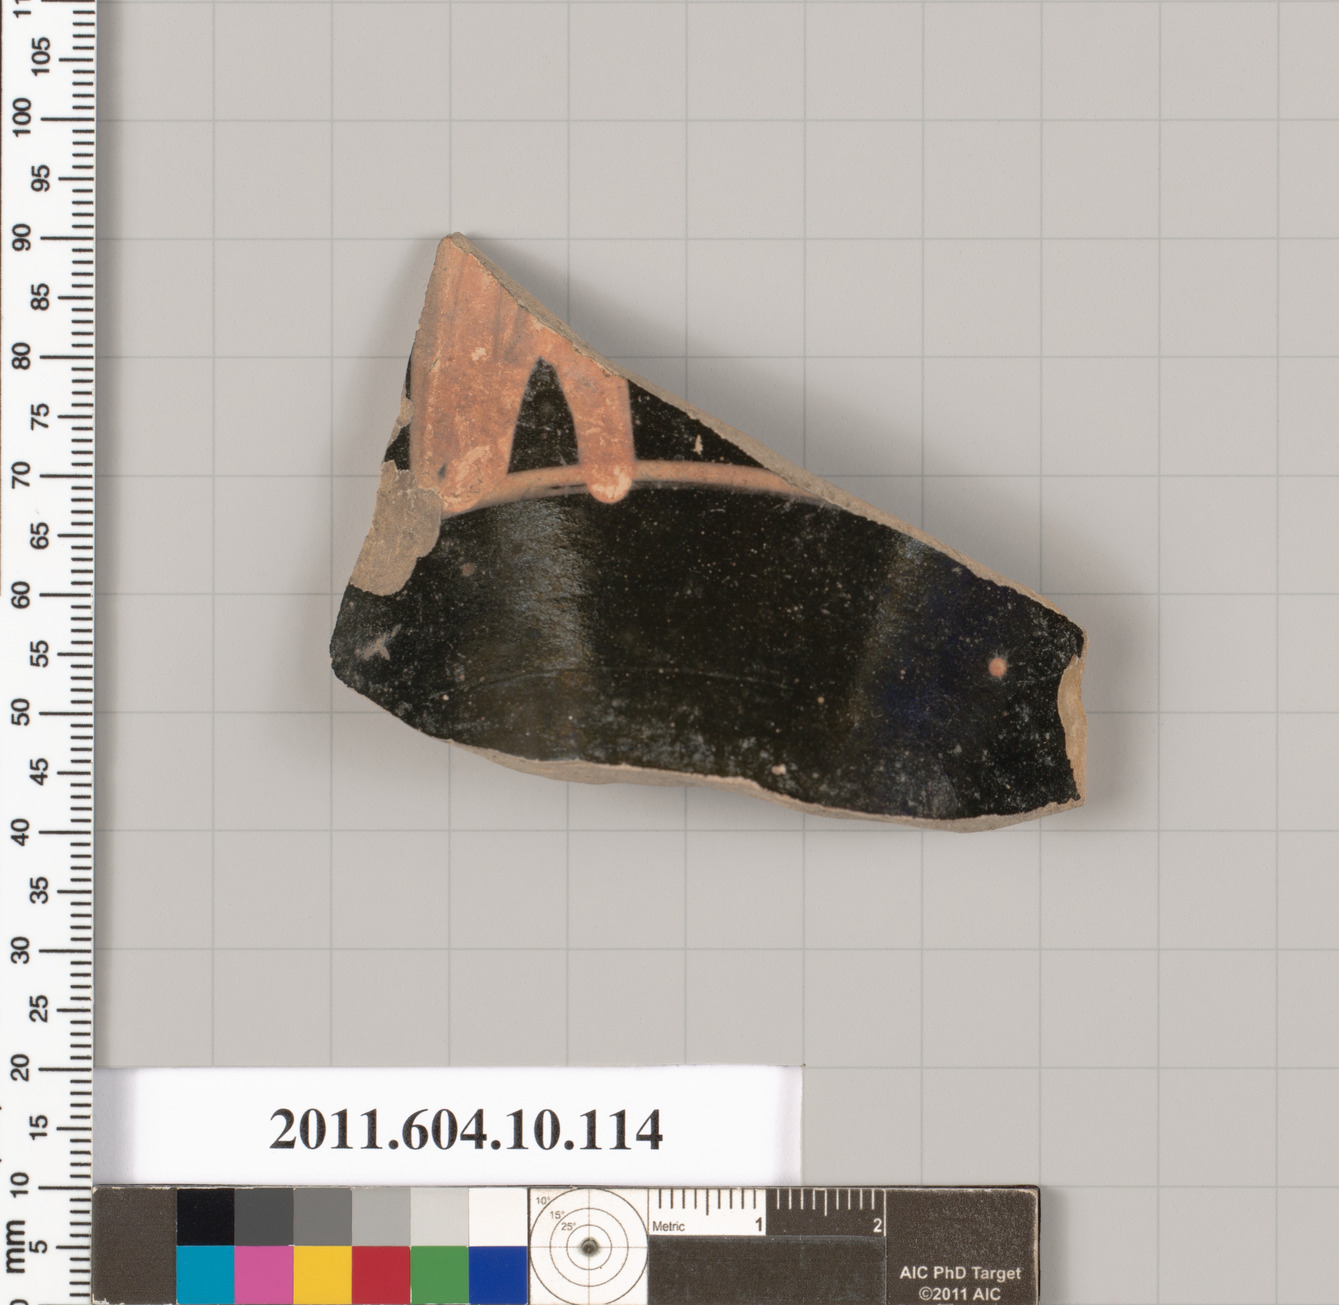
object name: undetermined open shape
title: Terracotta fragment of an open shape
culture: etruscan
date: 434-368 BCE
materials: terracotta